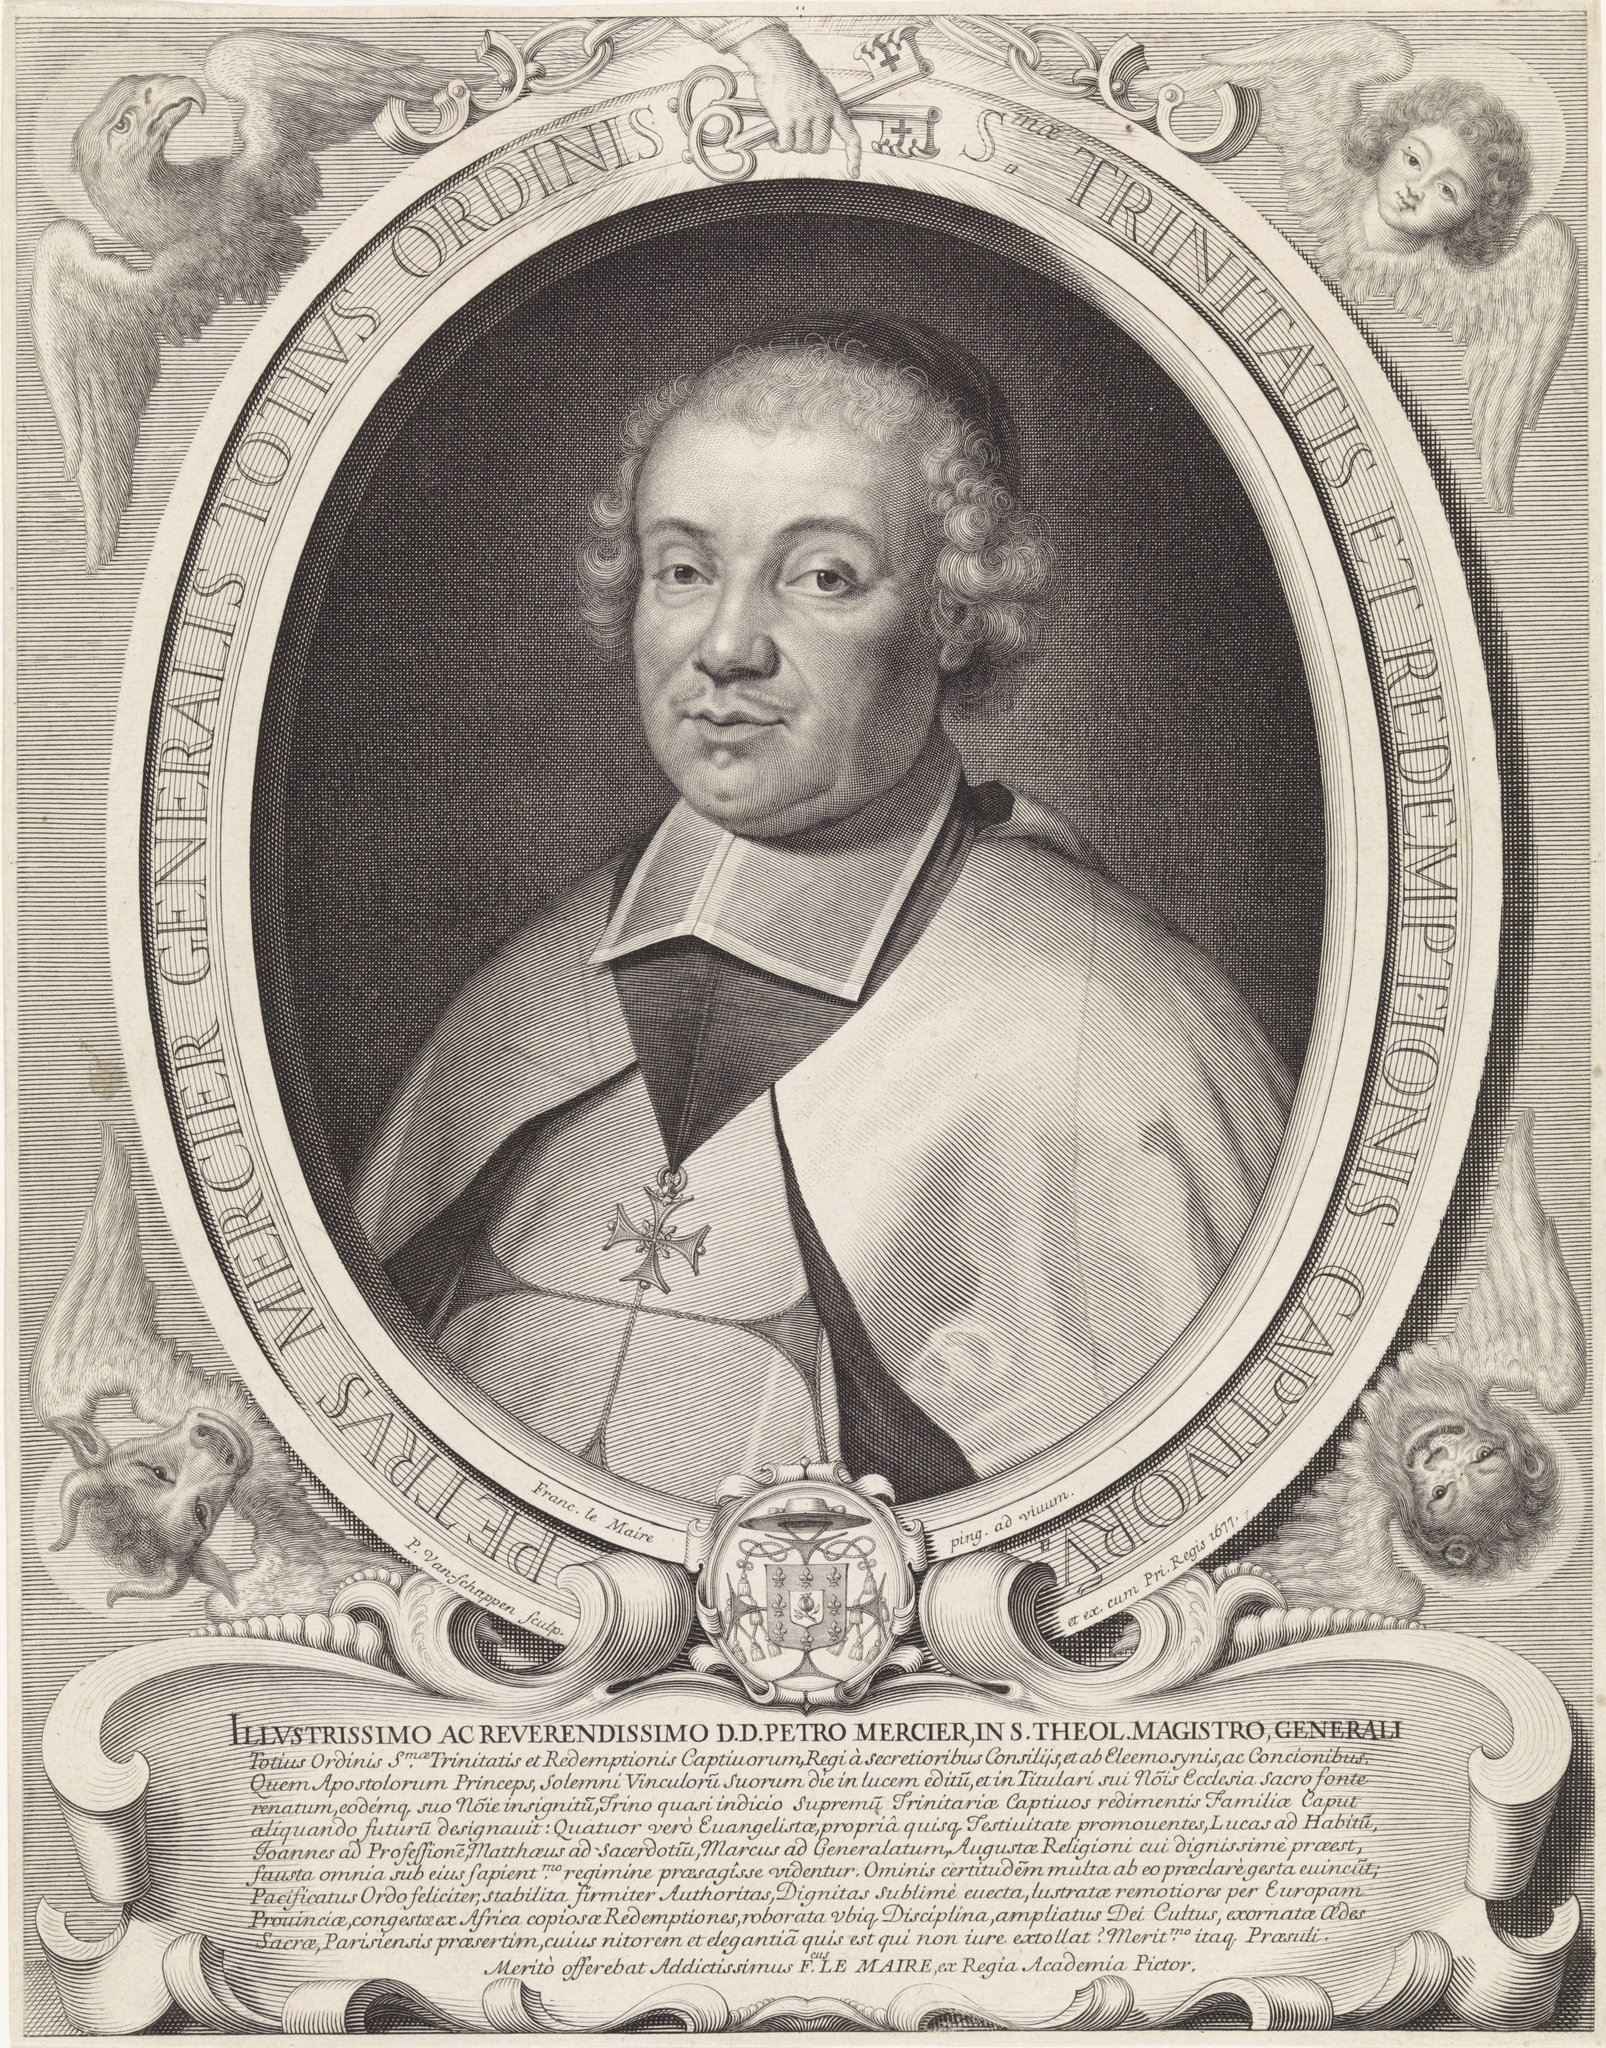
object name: print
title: Portret van Petrus Mercier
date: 1607-1677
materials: paper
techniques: engraving, etching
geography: paris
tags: petrus mercier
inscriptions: collector's mark: Lugt 2228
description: Portret van Petrus Mercier, magister-generaal van de Orde der Trinitariërs. Rondom het ovaal, waarin zijn naam en functie weergeven worden, staan de evangelistensymbolen: een gevleugelde adelaar, een gevleugelde mens, een gevleugelde leeuw en een gevleugeld rund. Boven het portret een hand die de sleutels van Petrus toont, daarbij wijzend naar Mercier. Ernaast twee gebroken ketens. Onder het portret een tekst in het Latijn, waarin de betekenis van Mercier voor de bedelorde beschreven wordt.